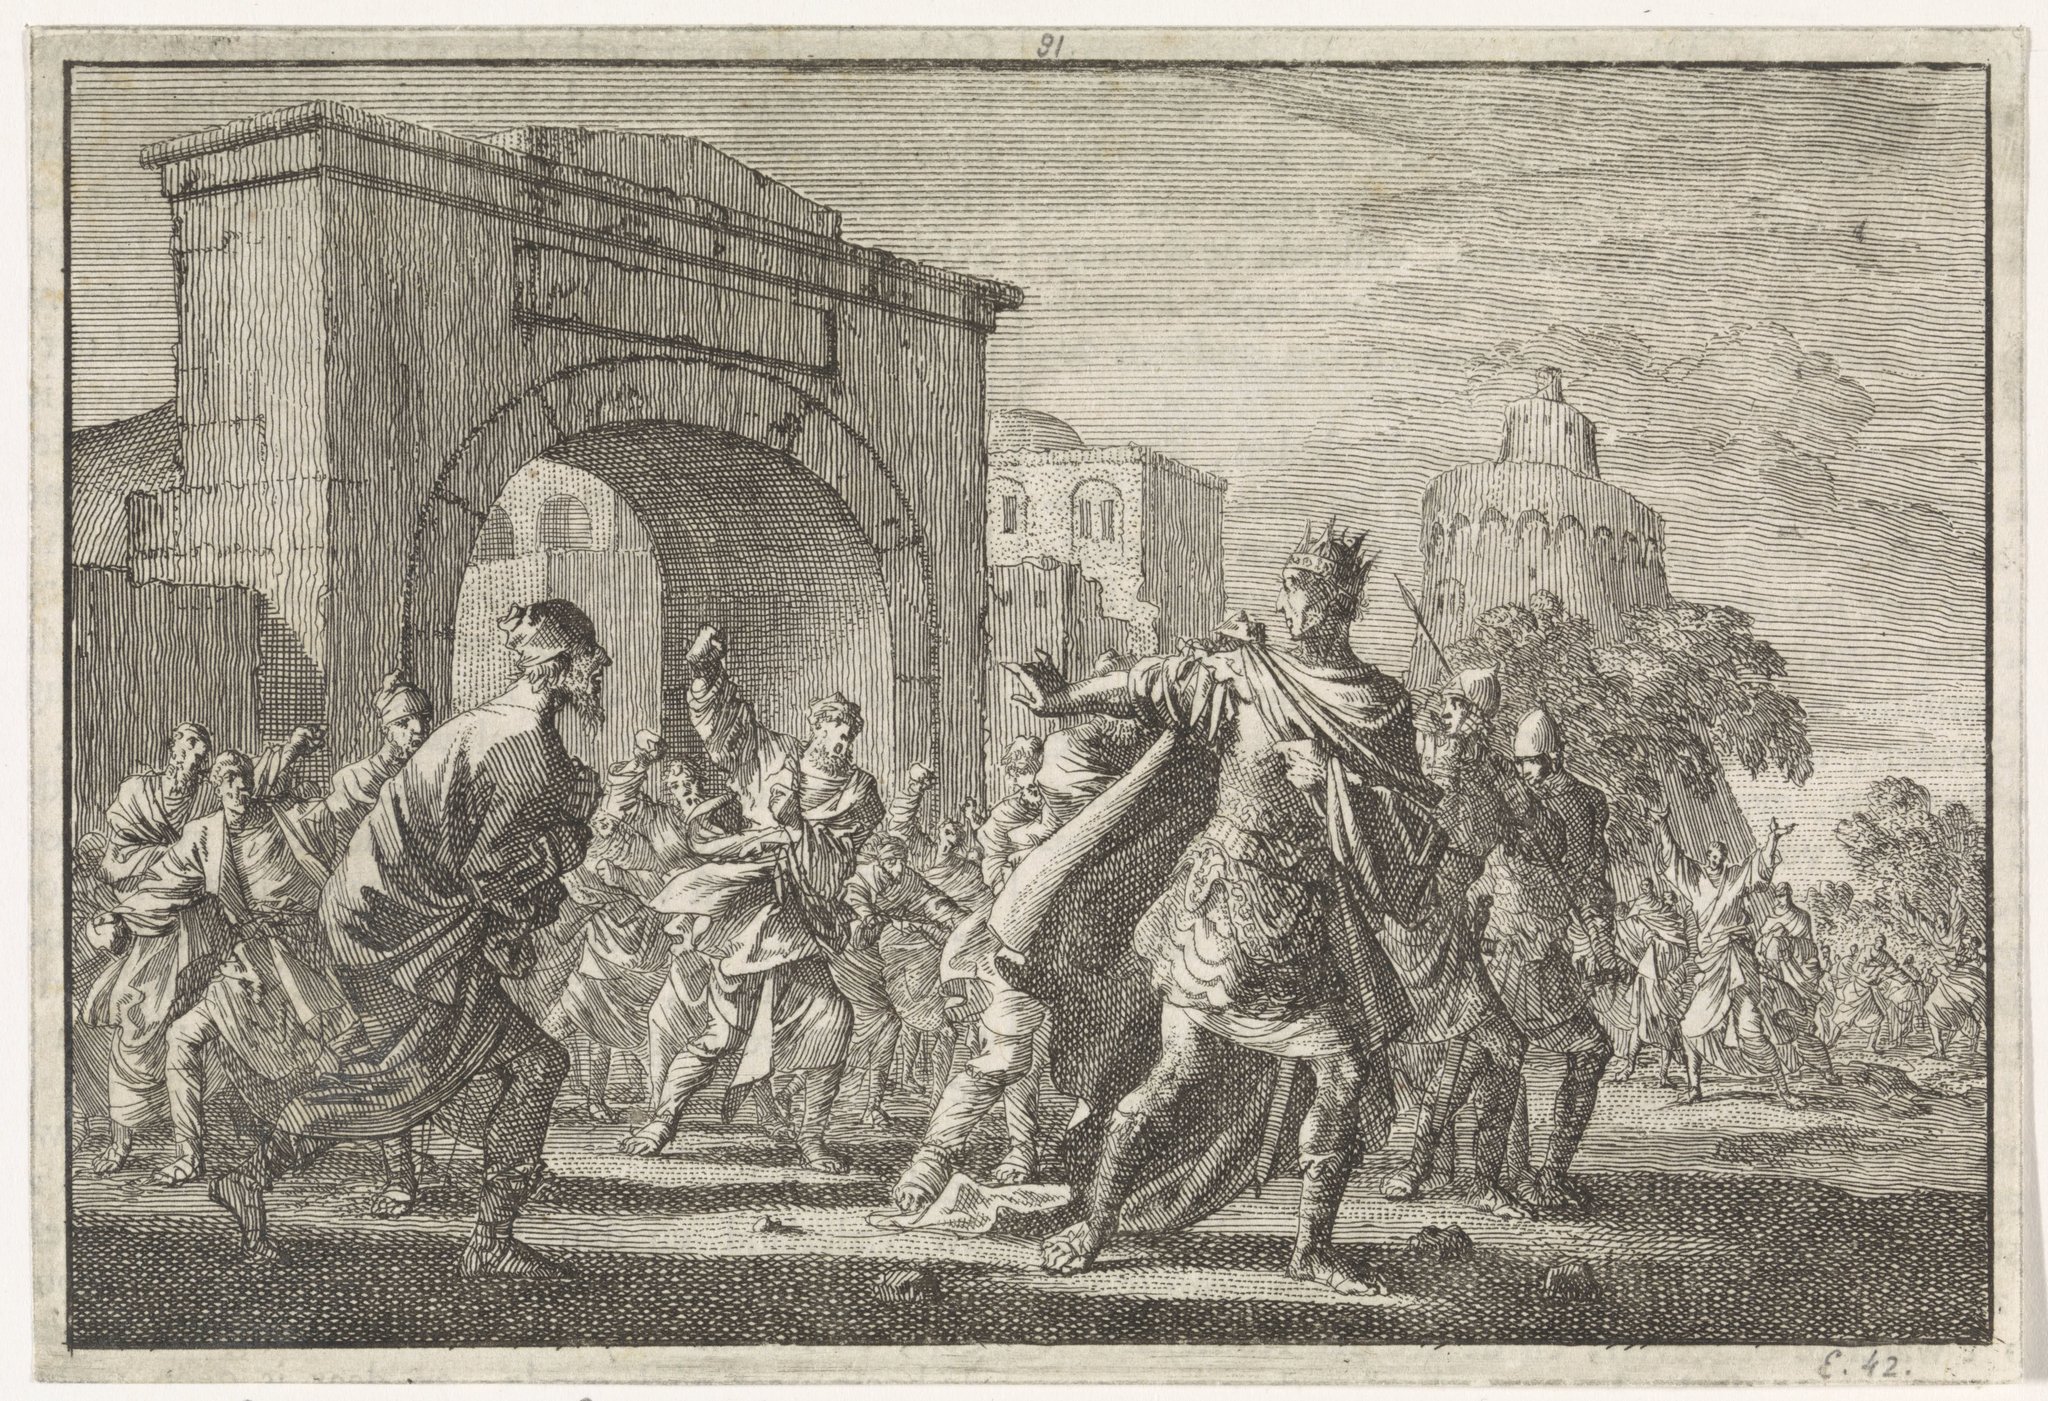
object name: print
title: Koning Agrippa wordt door de Joden met steenworpen uit Jeruzalem verjaagd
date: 1704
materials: paper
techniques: etching, letterpress printing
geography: amsterdam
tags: violent death by stoning - ee - death not certain; wounded person, banishment, exile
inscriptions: collector's mark: Lugt 2228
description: Prent opgenomen in: Josephus, Flavius. Alle de Werken, 2 delen. Amsterdam: Pieter Mortier, 1704, dl. 2, p. 42.